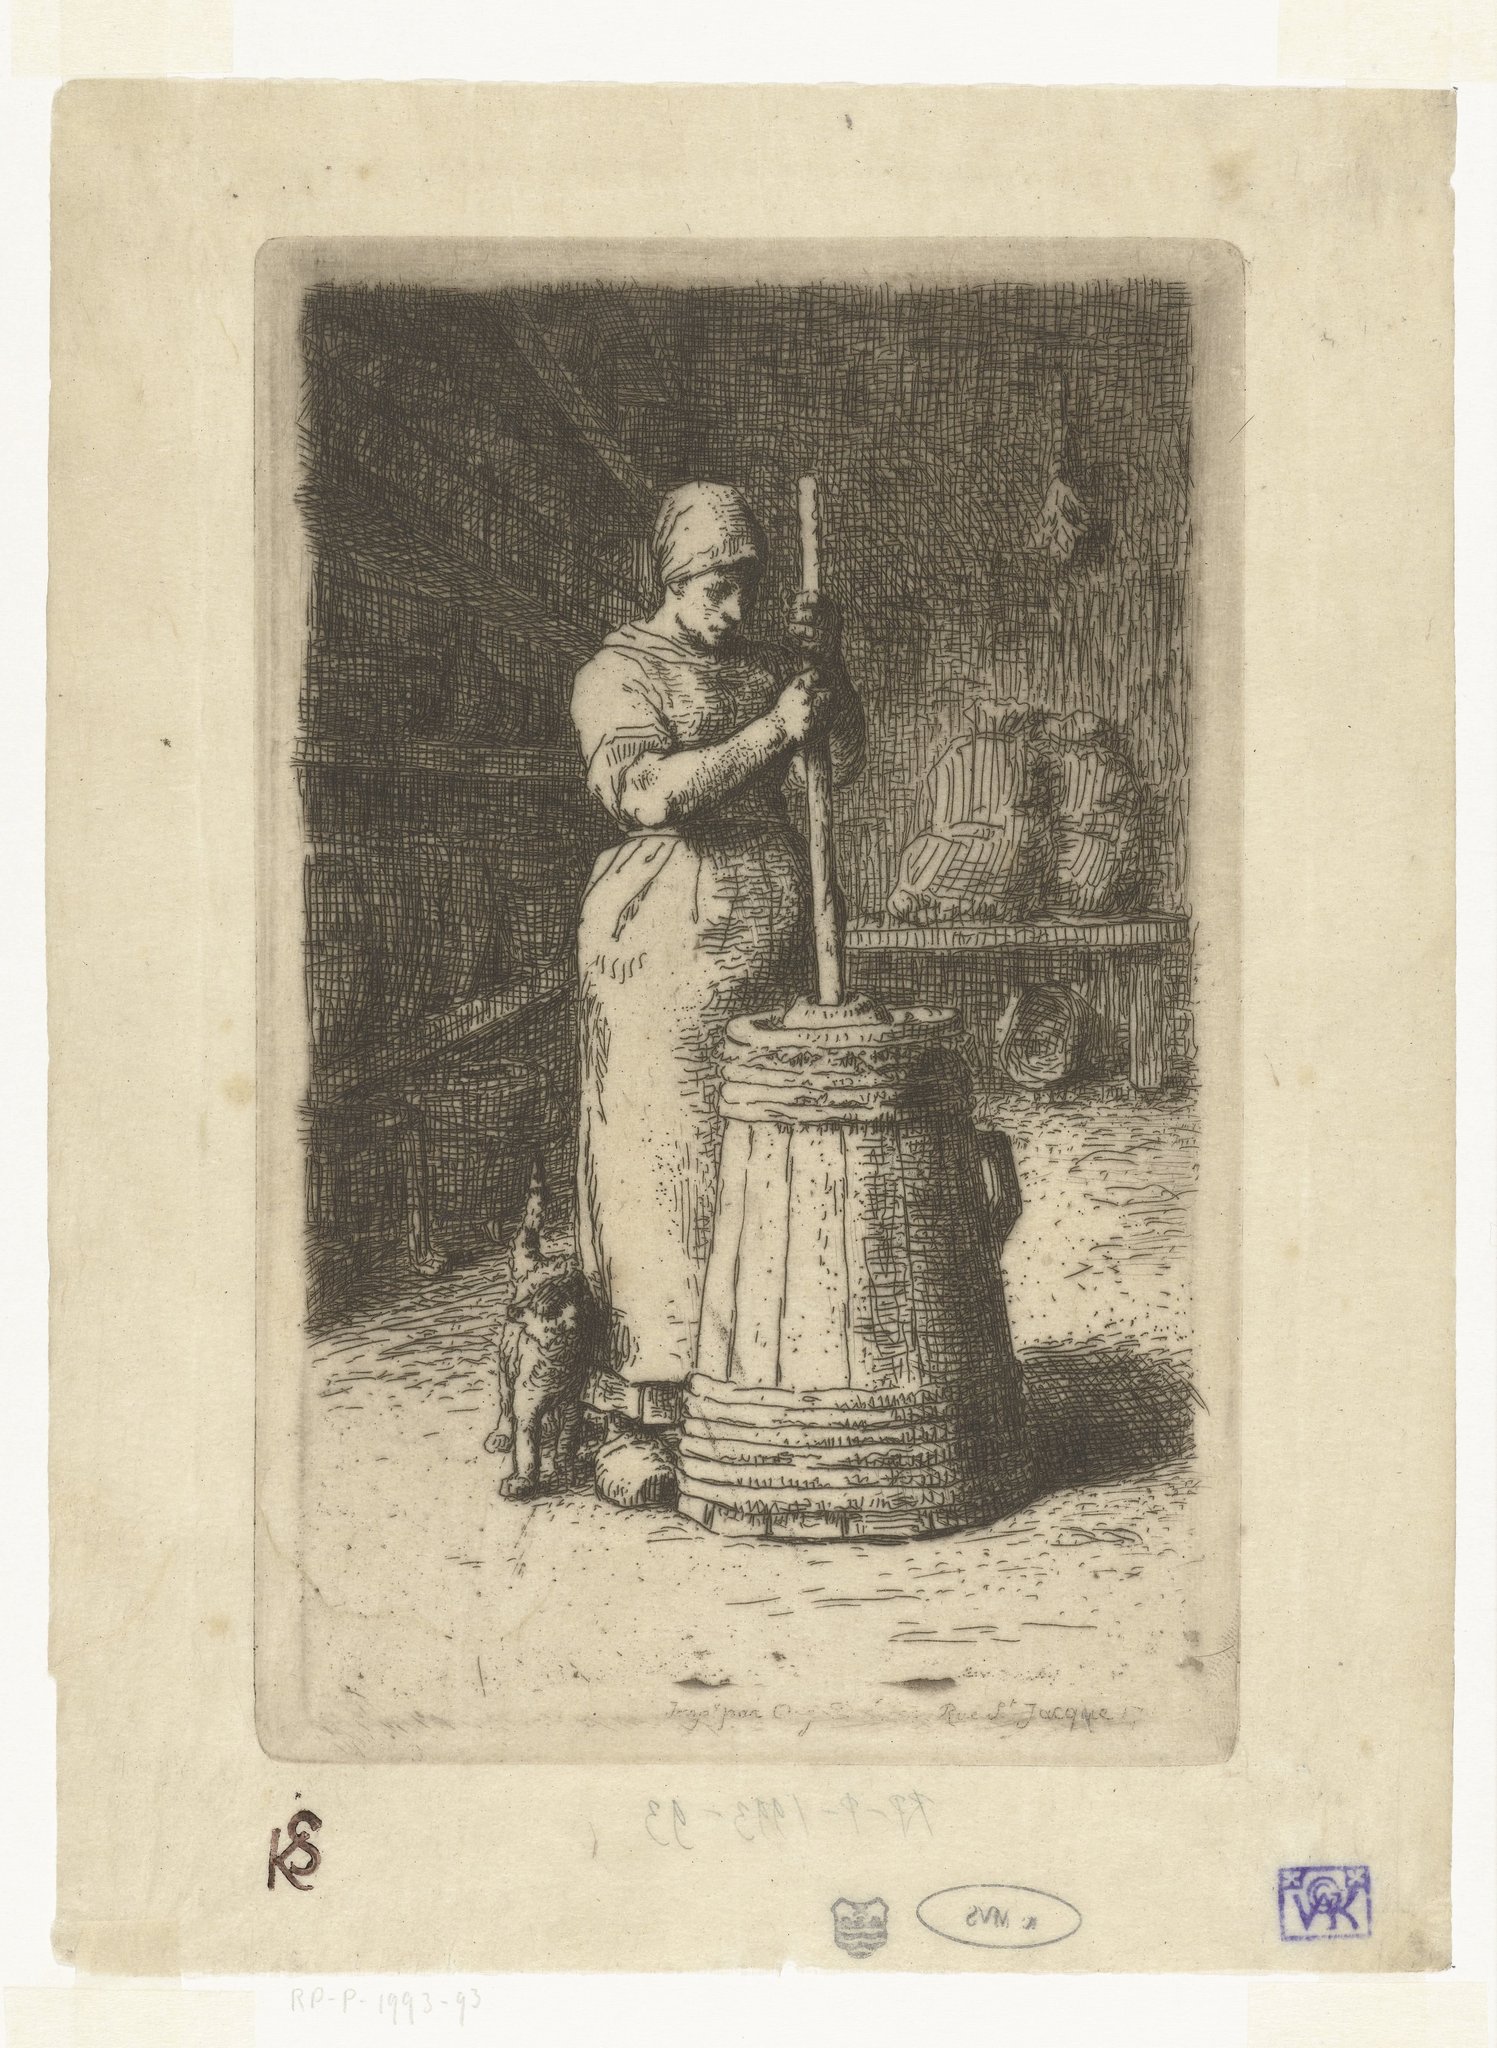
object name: print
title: Vrouw karnt melk in karnton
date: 1855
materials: paper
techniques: etching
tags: buttermilk, churning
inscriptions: collector's mark: Lugt 2228, collector's mark: Lugt 2521a, collector's mark, collector's mark: Lugt 2760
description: Een vrouw karnt melk met een karnstok in een karnton. Ze staat in een opslagruimte van voorraad. Een kat draait om haar benen.